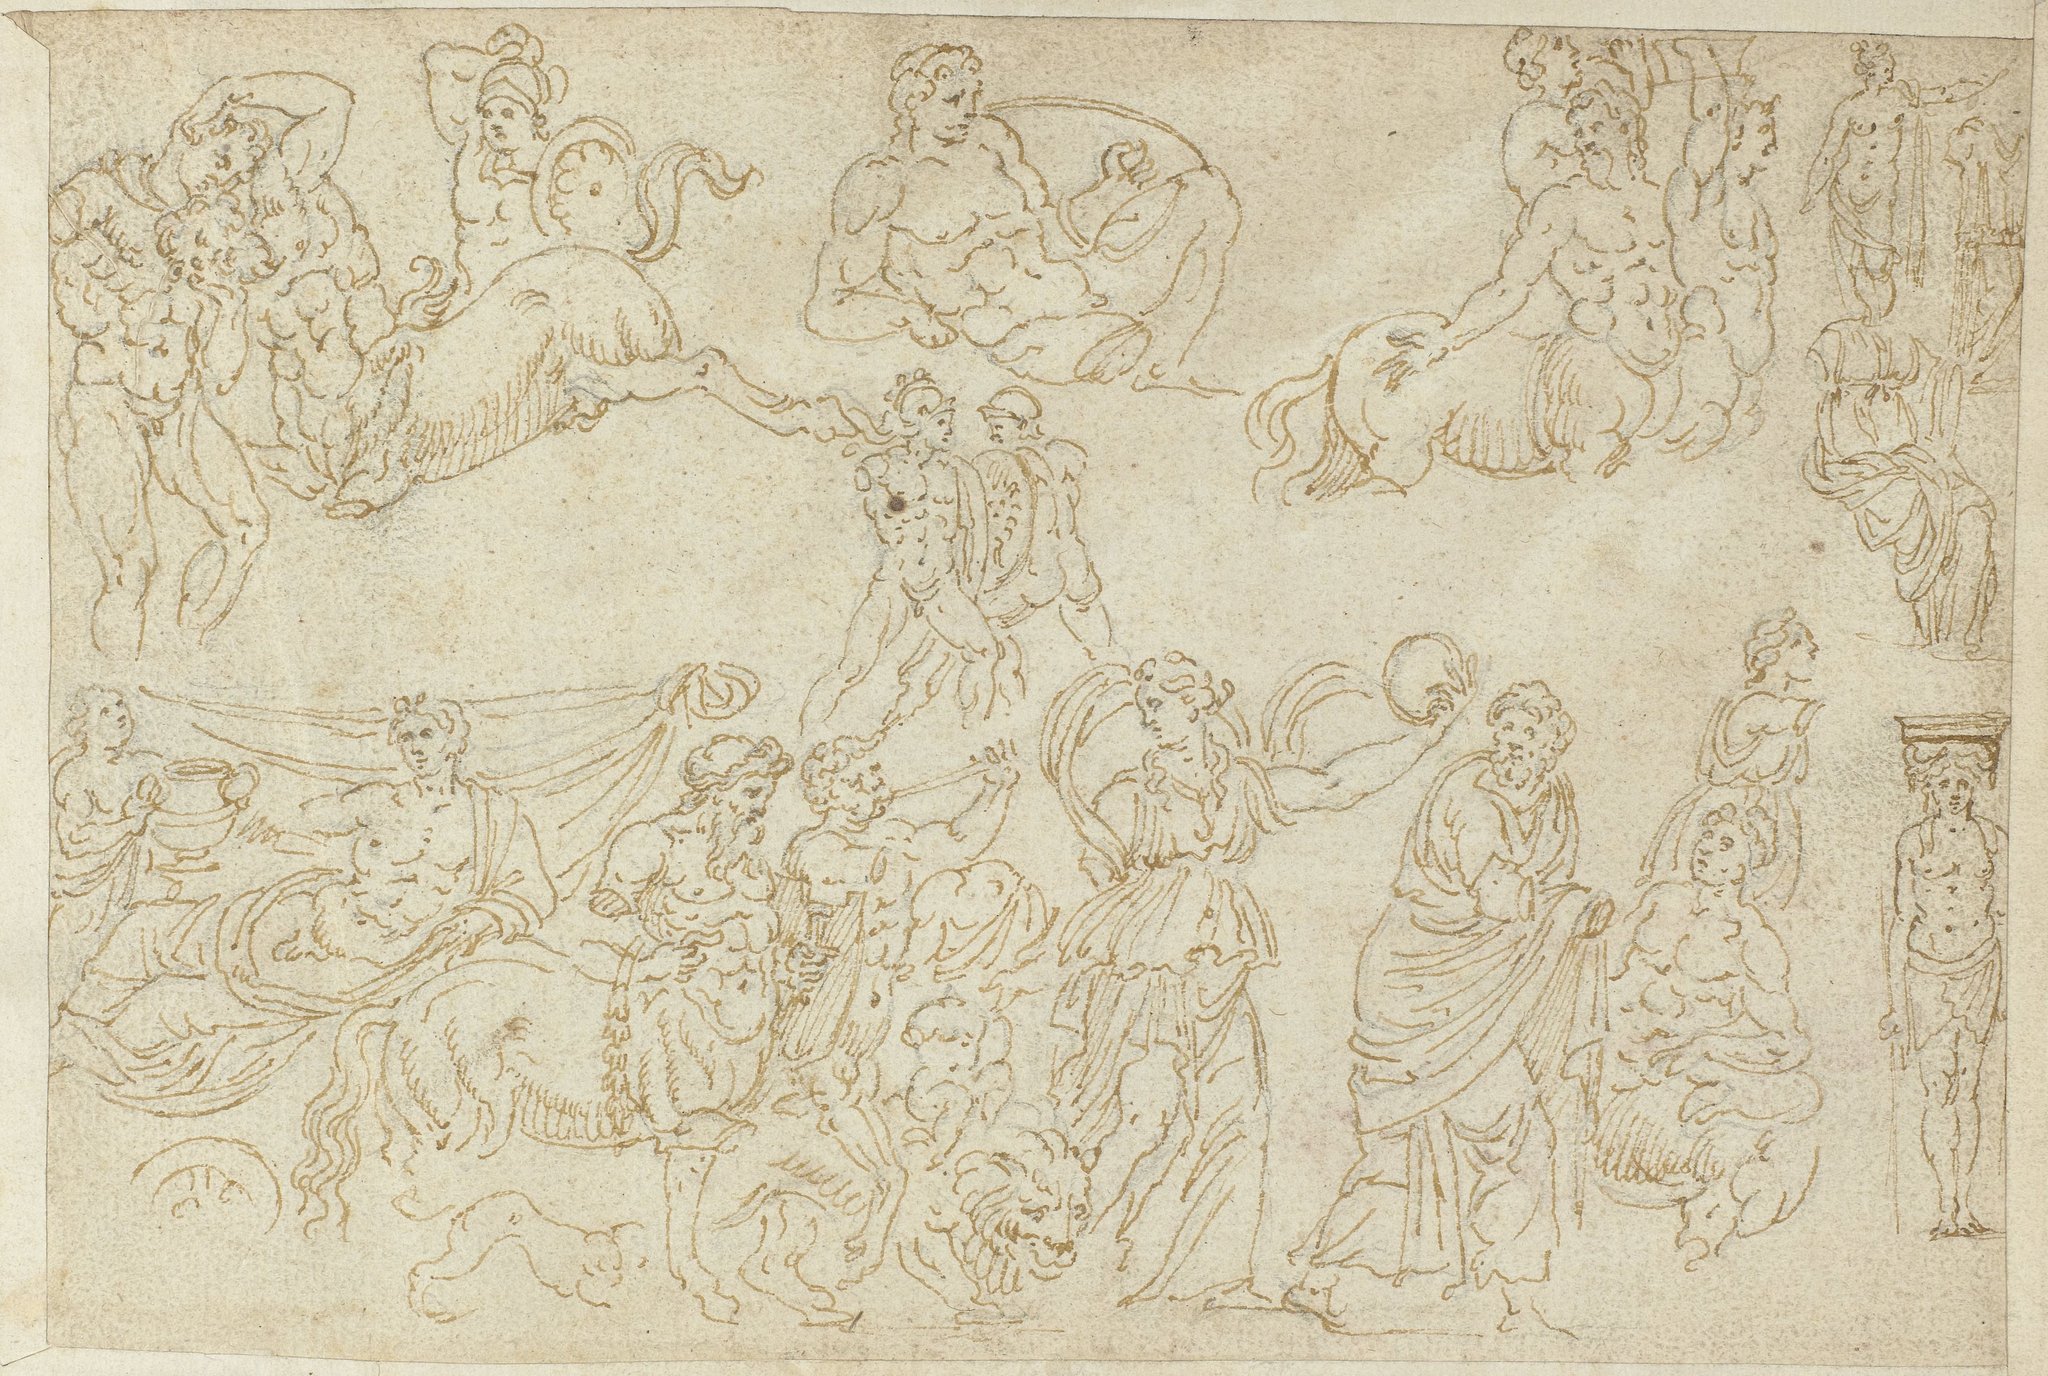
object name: kopie naar tekening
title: Voorstellingen van sarcofagen en beelden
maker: Anonymous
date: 1550-1570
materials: chalk, ink, paper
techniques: pen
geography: low countries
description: Album "Maarten de Vos schetsboek", blad 12v(12).